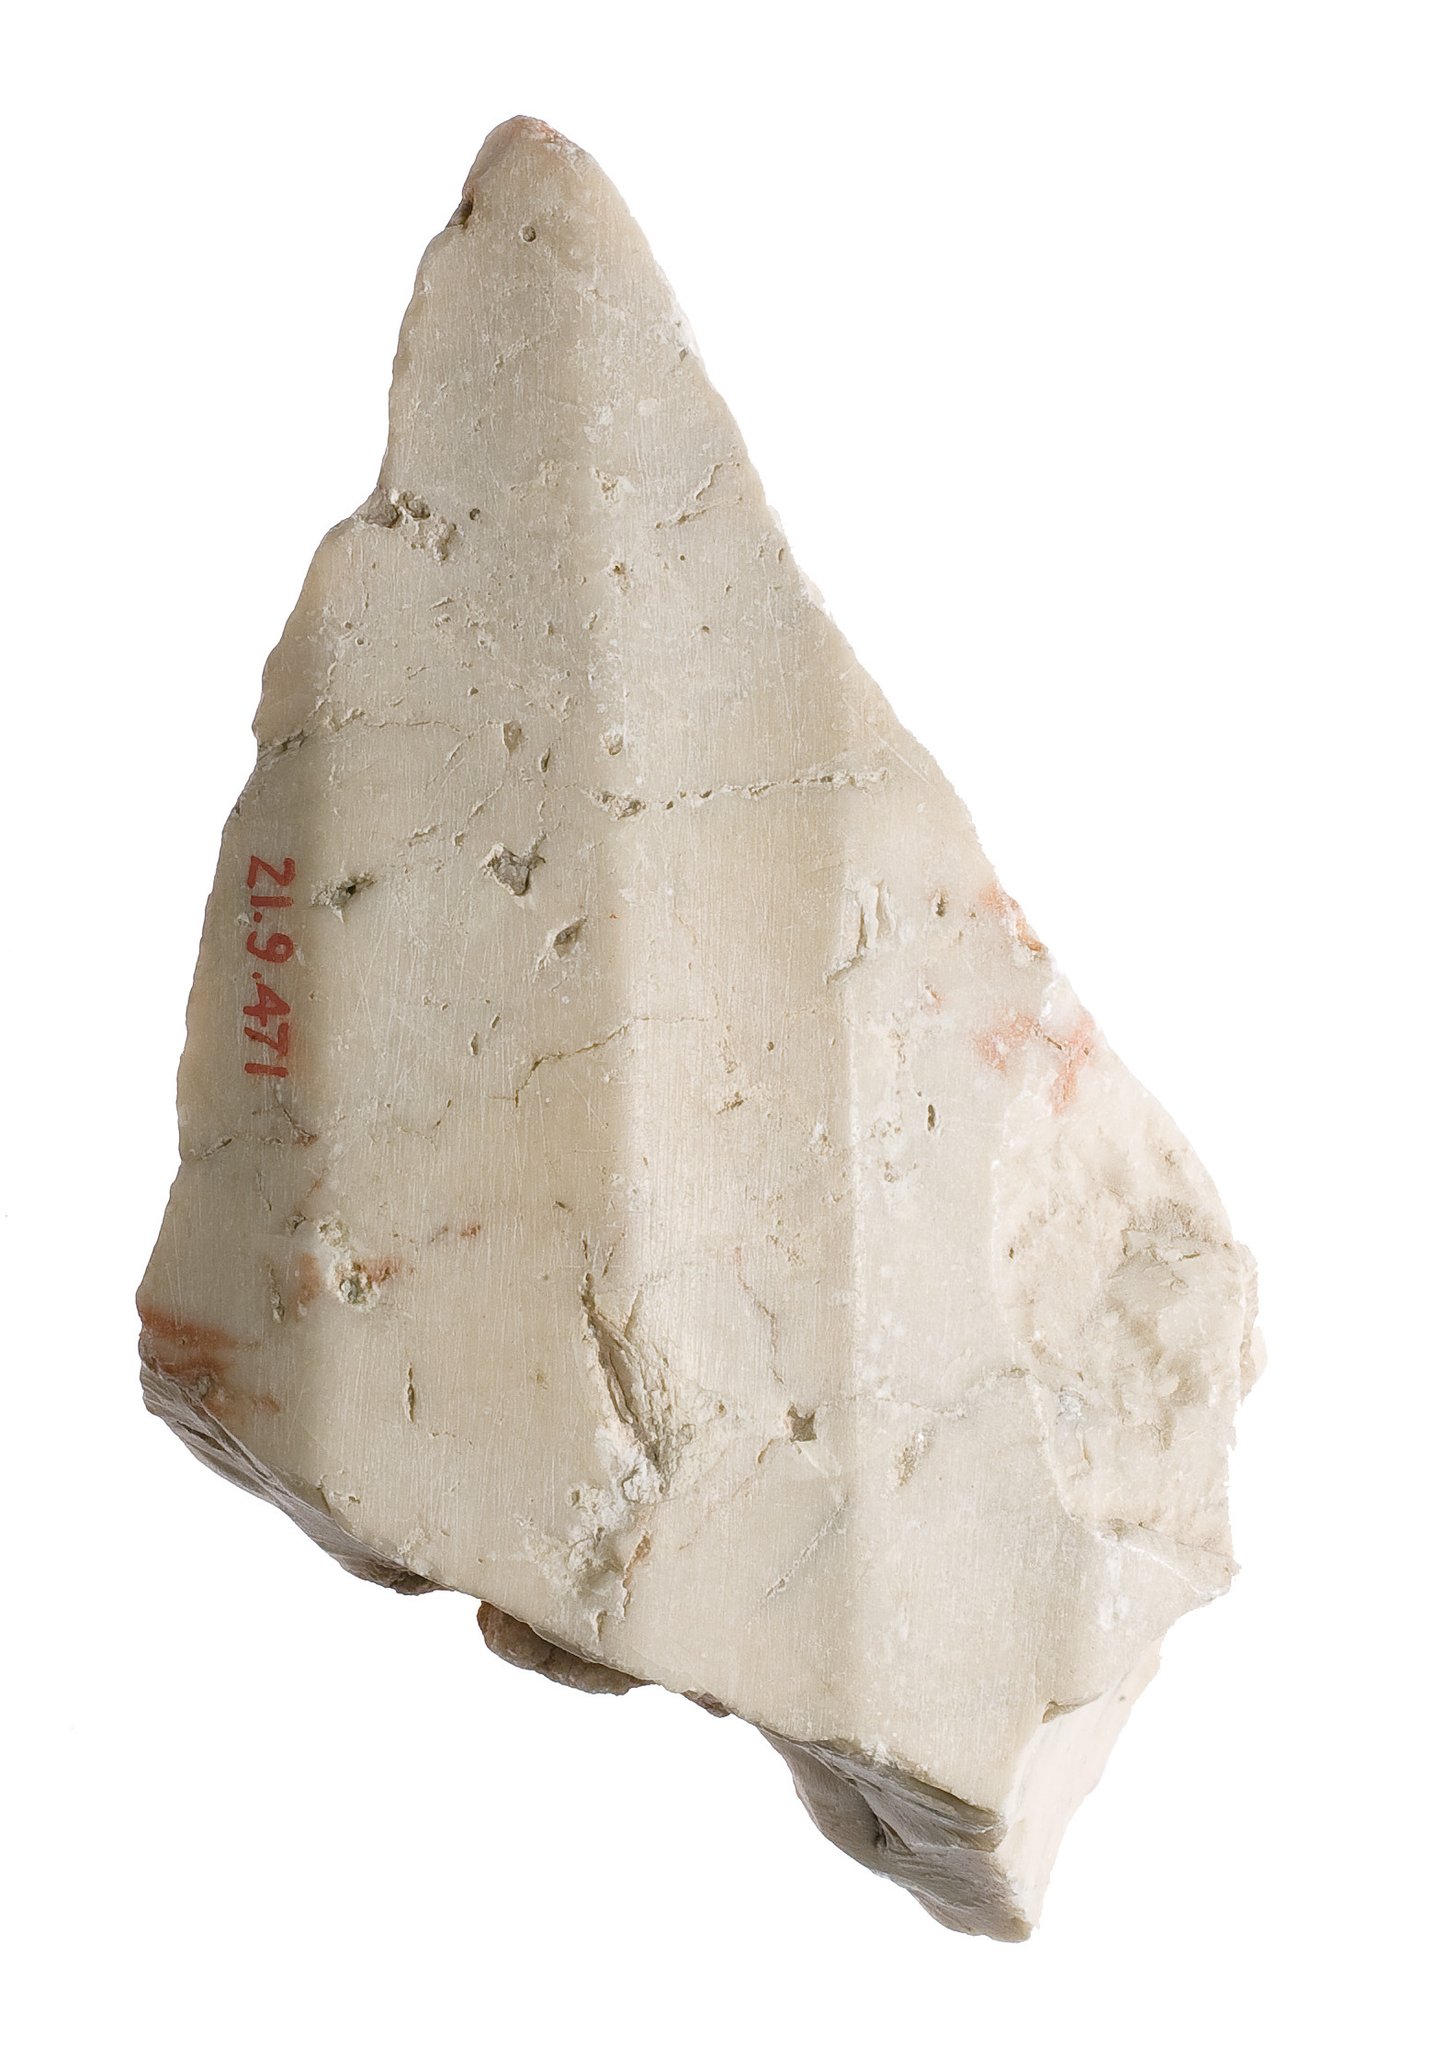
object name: body thigh with garment, pleated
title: Body (thigh ?) with garment, pleated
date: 1353-1336 BCE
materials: limestone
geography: egypt